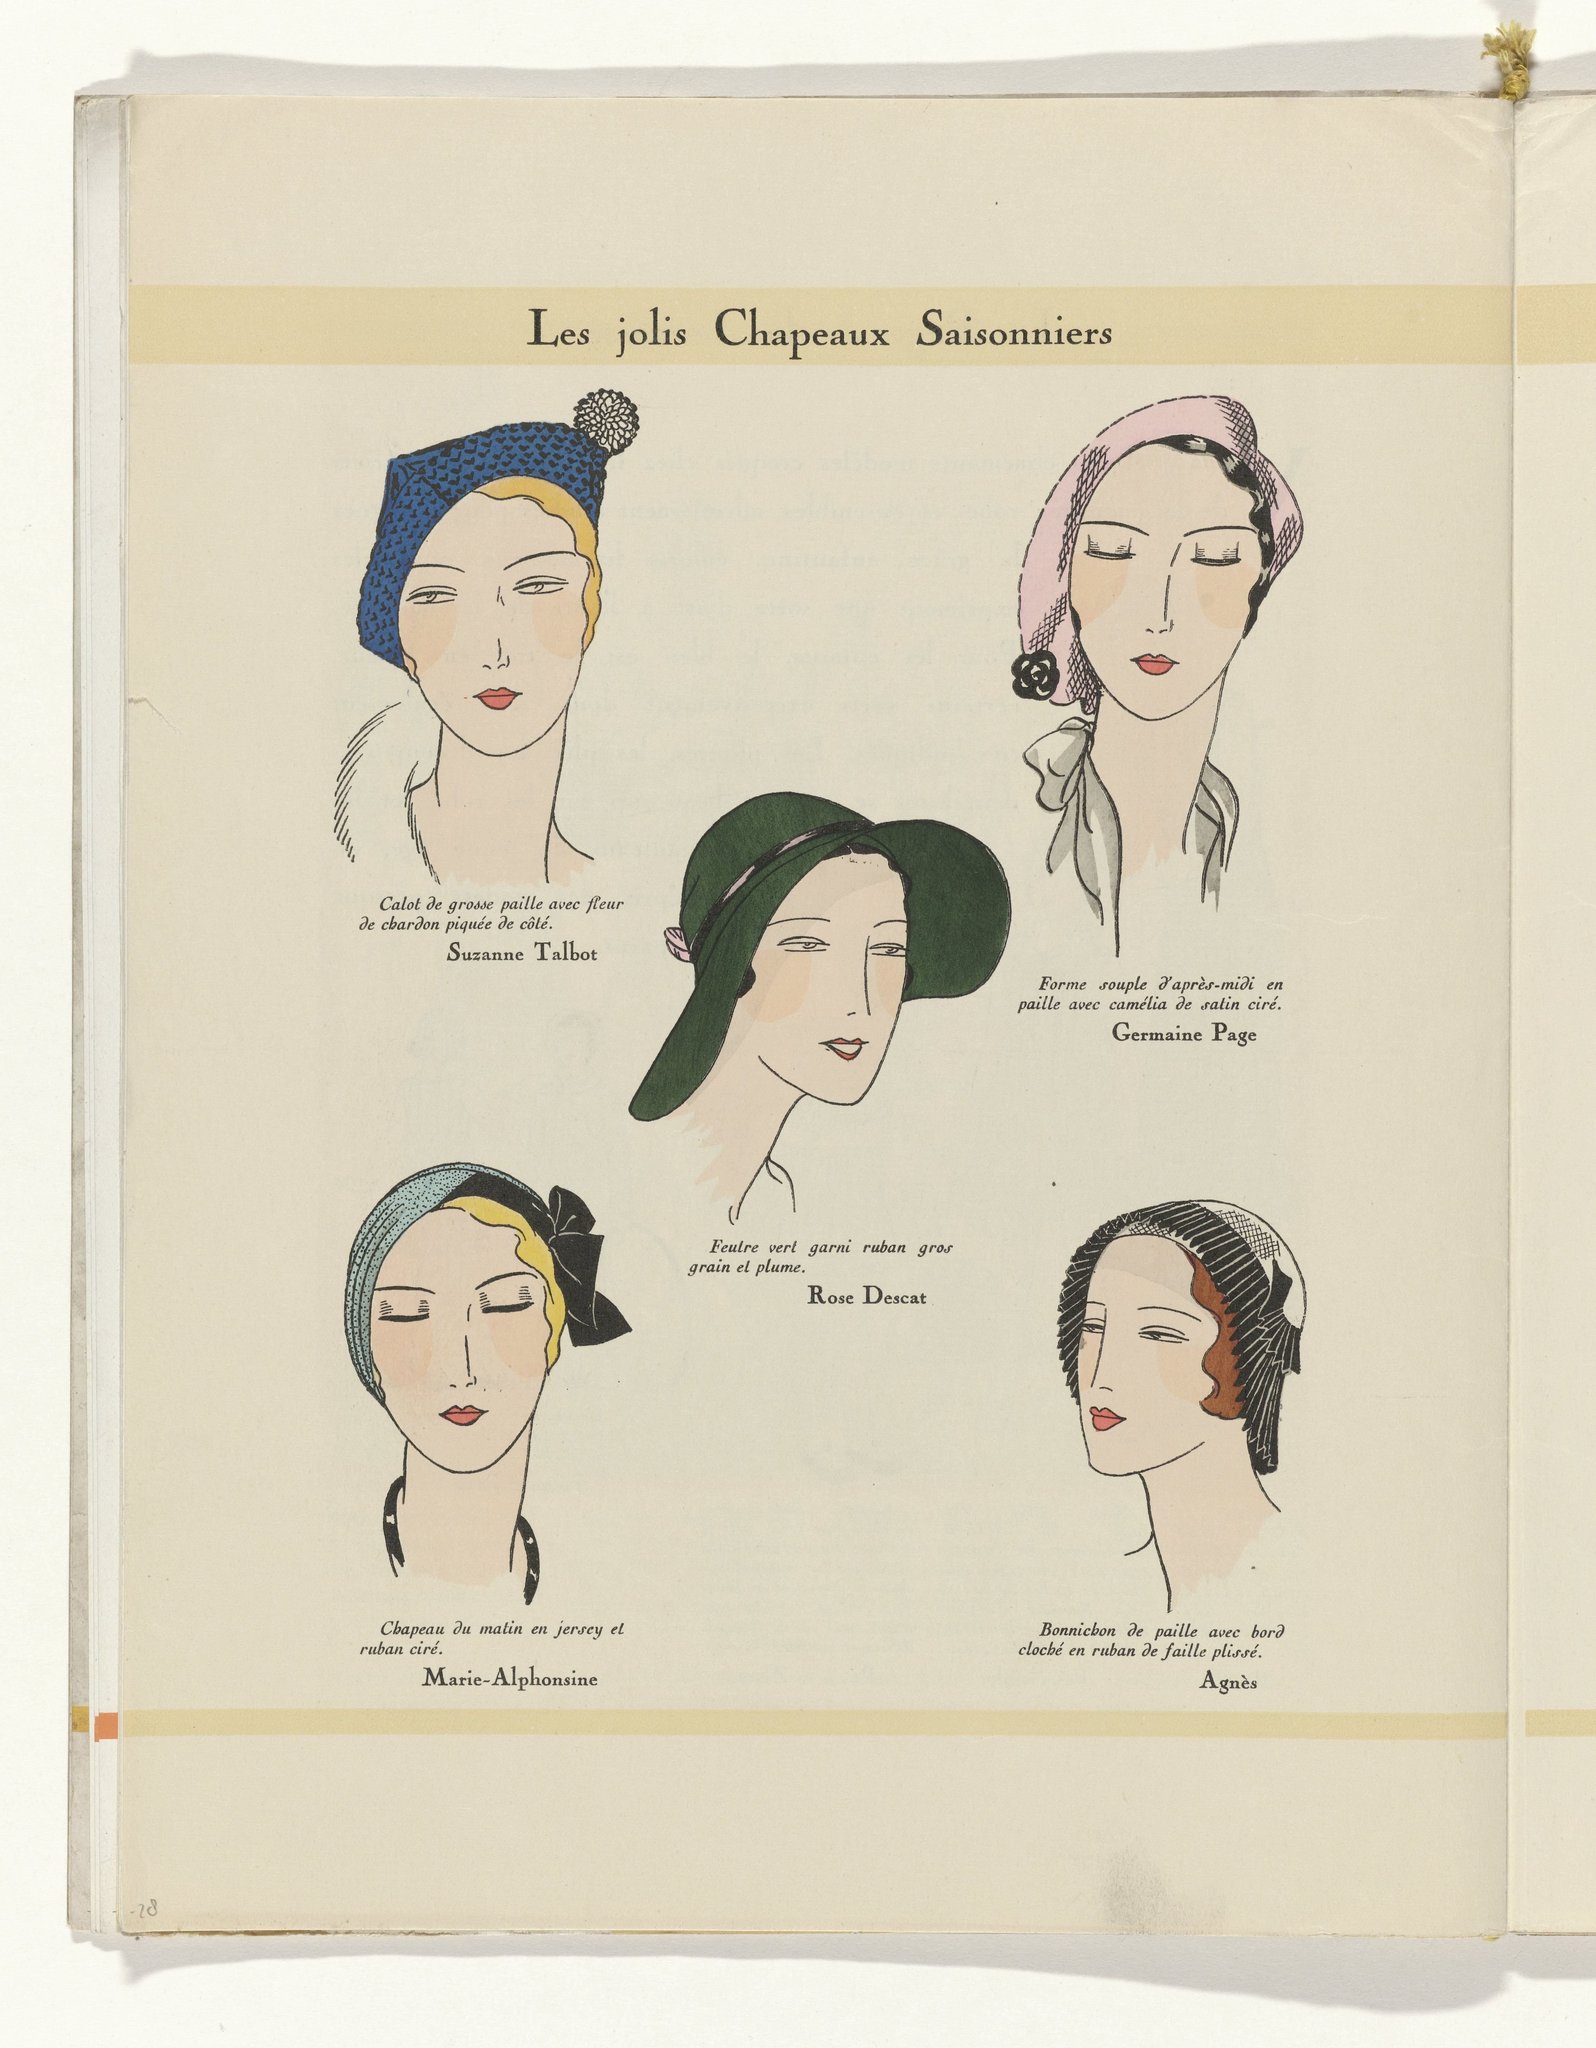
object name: magazine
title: Art - Goût - Beauté, Feuillets de l' élégance féminine, Mai 1931, No. 129, 11e Année, p. 28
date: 1931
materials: paper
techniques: hand coloring, lithograph, pochoir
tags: fashion plates, head-gear: hat (+ women's clothes)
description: Les jolis Chapeaux Saisonniers. Vijf hoeden vor het nieuwe seizoen. Kalot met bloem van Suzanne Talbot; soepele baret van Germaine Page, groene vilthoed van Rose Descat, hoedje van jersey voor de ochtend van Marie-Alphonsine en een 'Bonnichon' van Agnès. Pagina uit het modetijdschrift Art-Goût-Beauté (1920-1933).